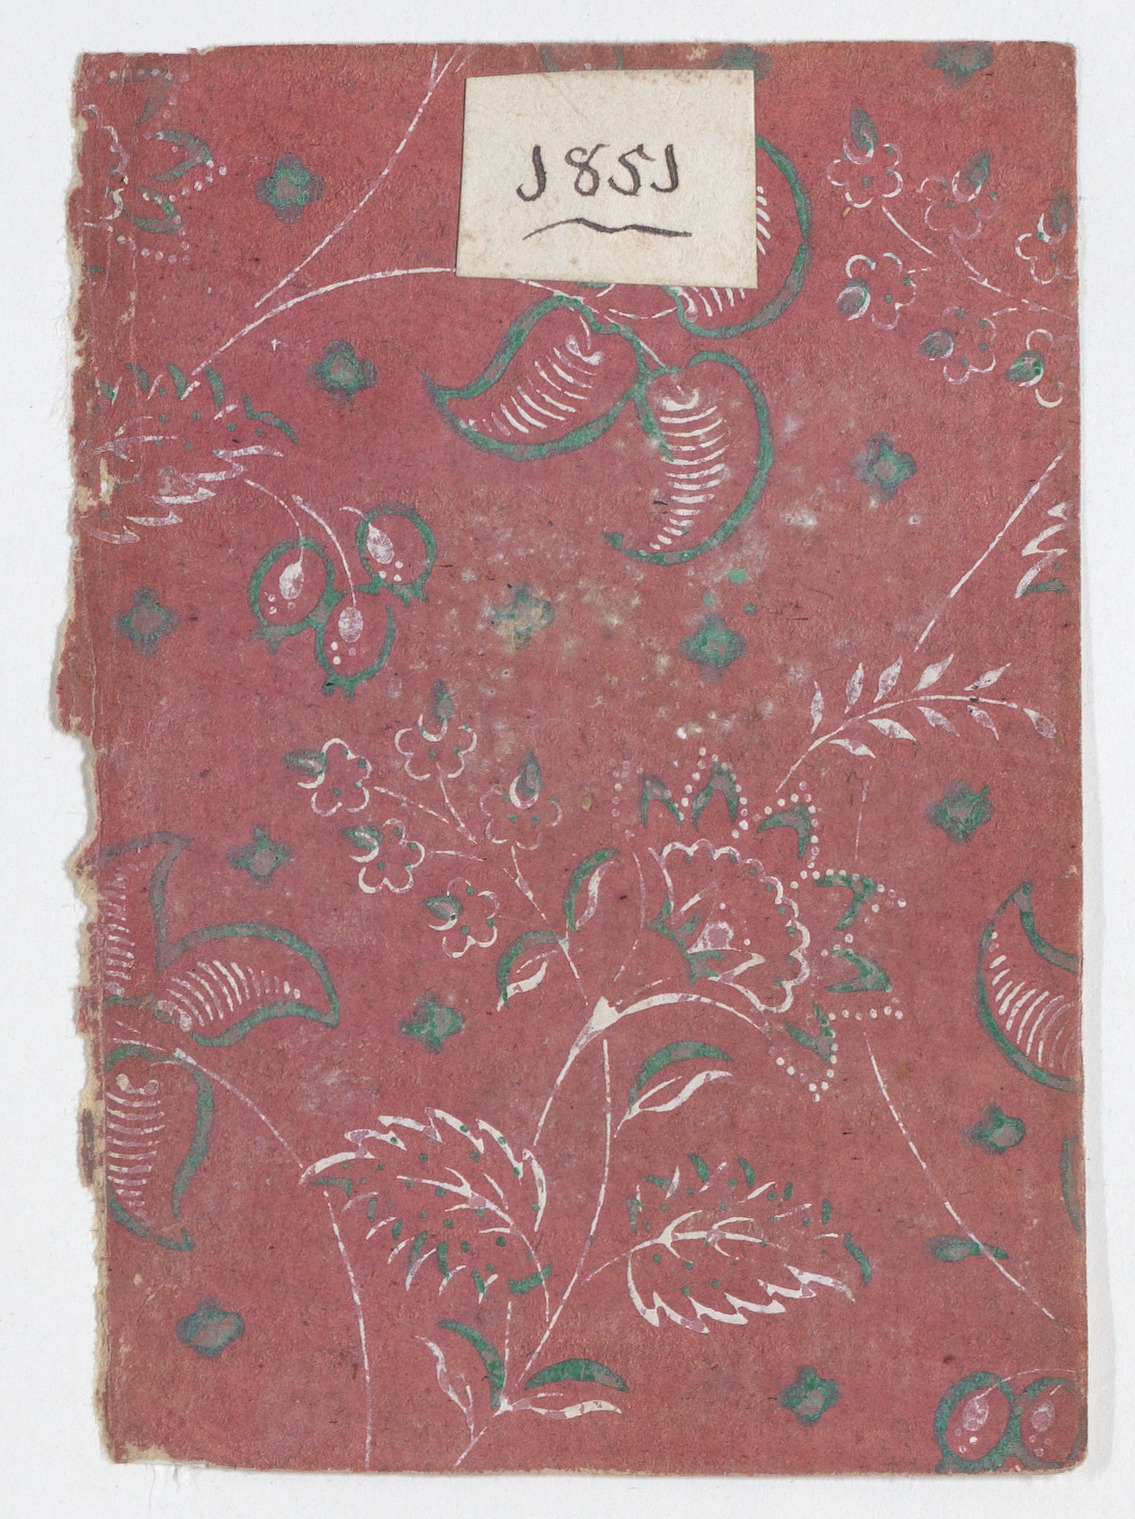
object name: print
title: Red book cover with floral and vine pattern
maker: Anonymous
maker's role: artist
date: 1851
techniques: relief print